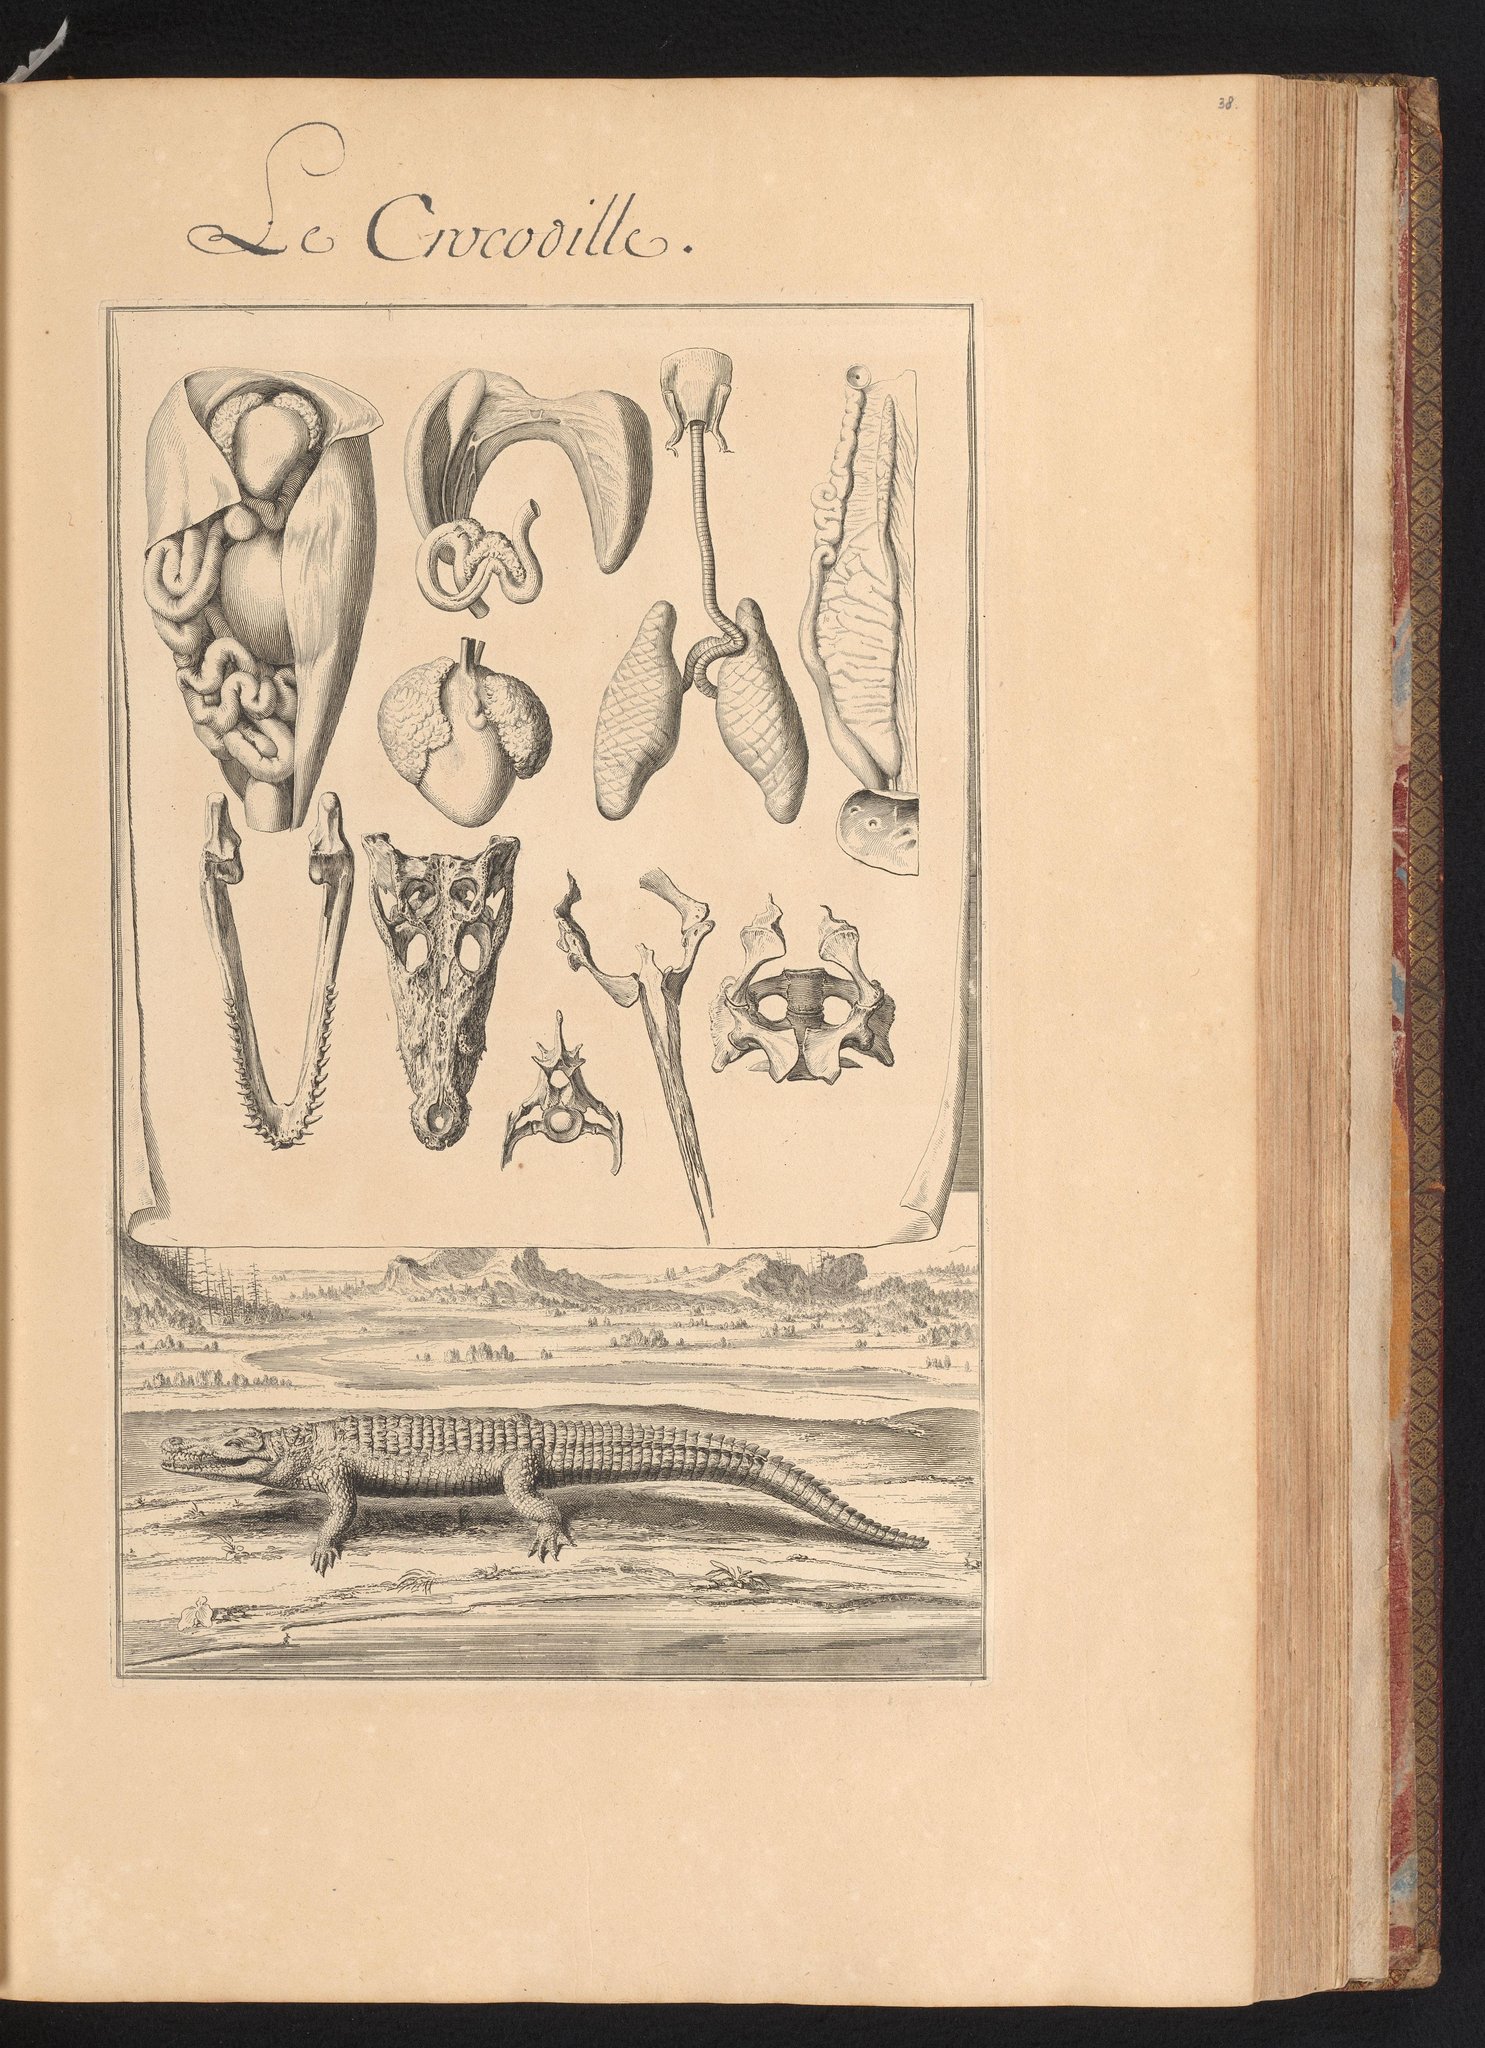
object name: book illustration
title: Krokodil in een landschap met bovenaan op een blad de organen en botten van het dier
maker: louis de châtillon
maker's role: print maker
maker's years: 1639-1734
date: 1649-1734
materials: ink, paper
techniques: engraving, etching, pen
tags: dissection, crocodiles: crocodile, animals (+ anatomy of animals)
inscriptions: inscription: ‘Le Crocodille.’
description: Prent bedoeld voor een editie van Claude Perraults 'Mémoires pour servir à l'histoire naturelle des animaux'.